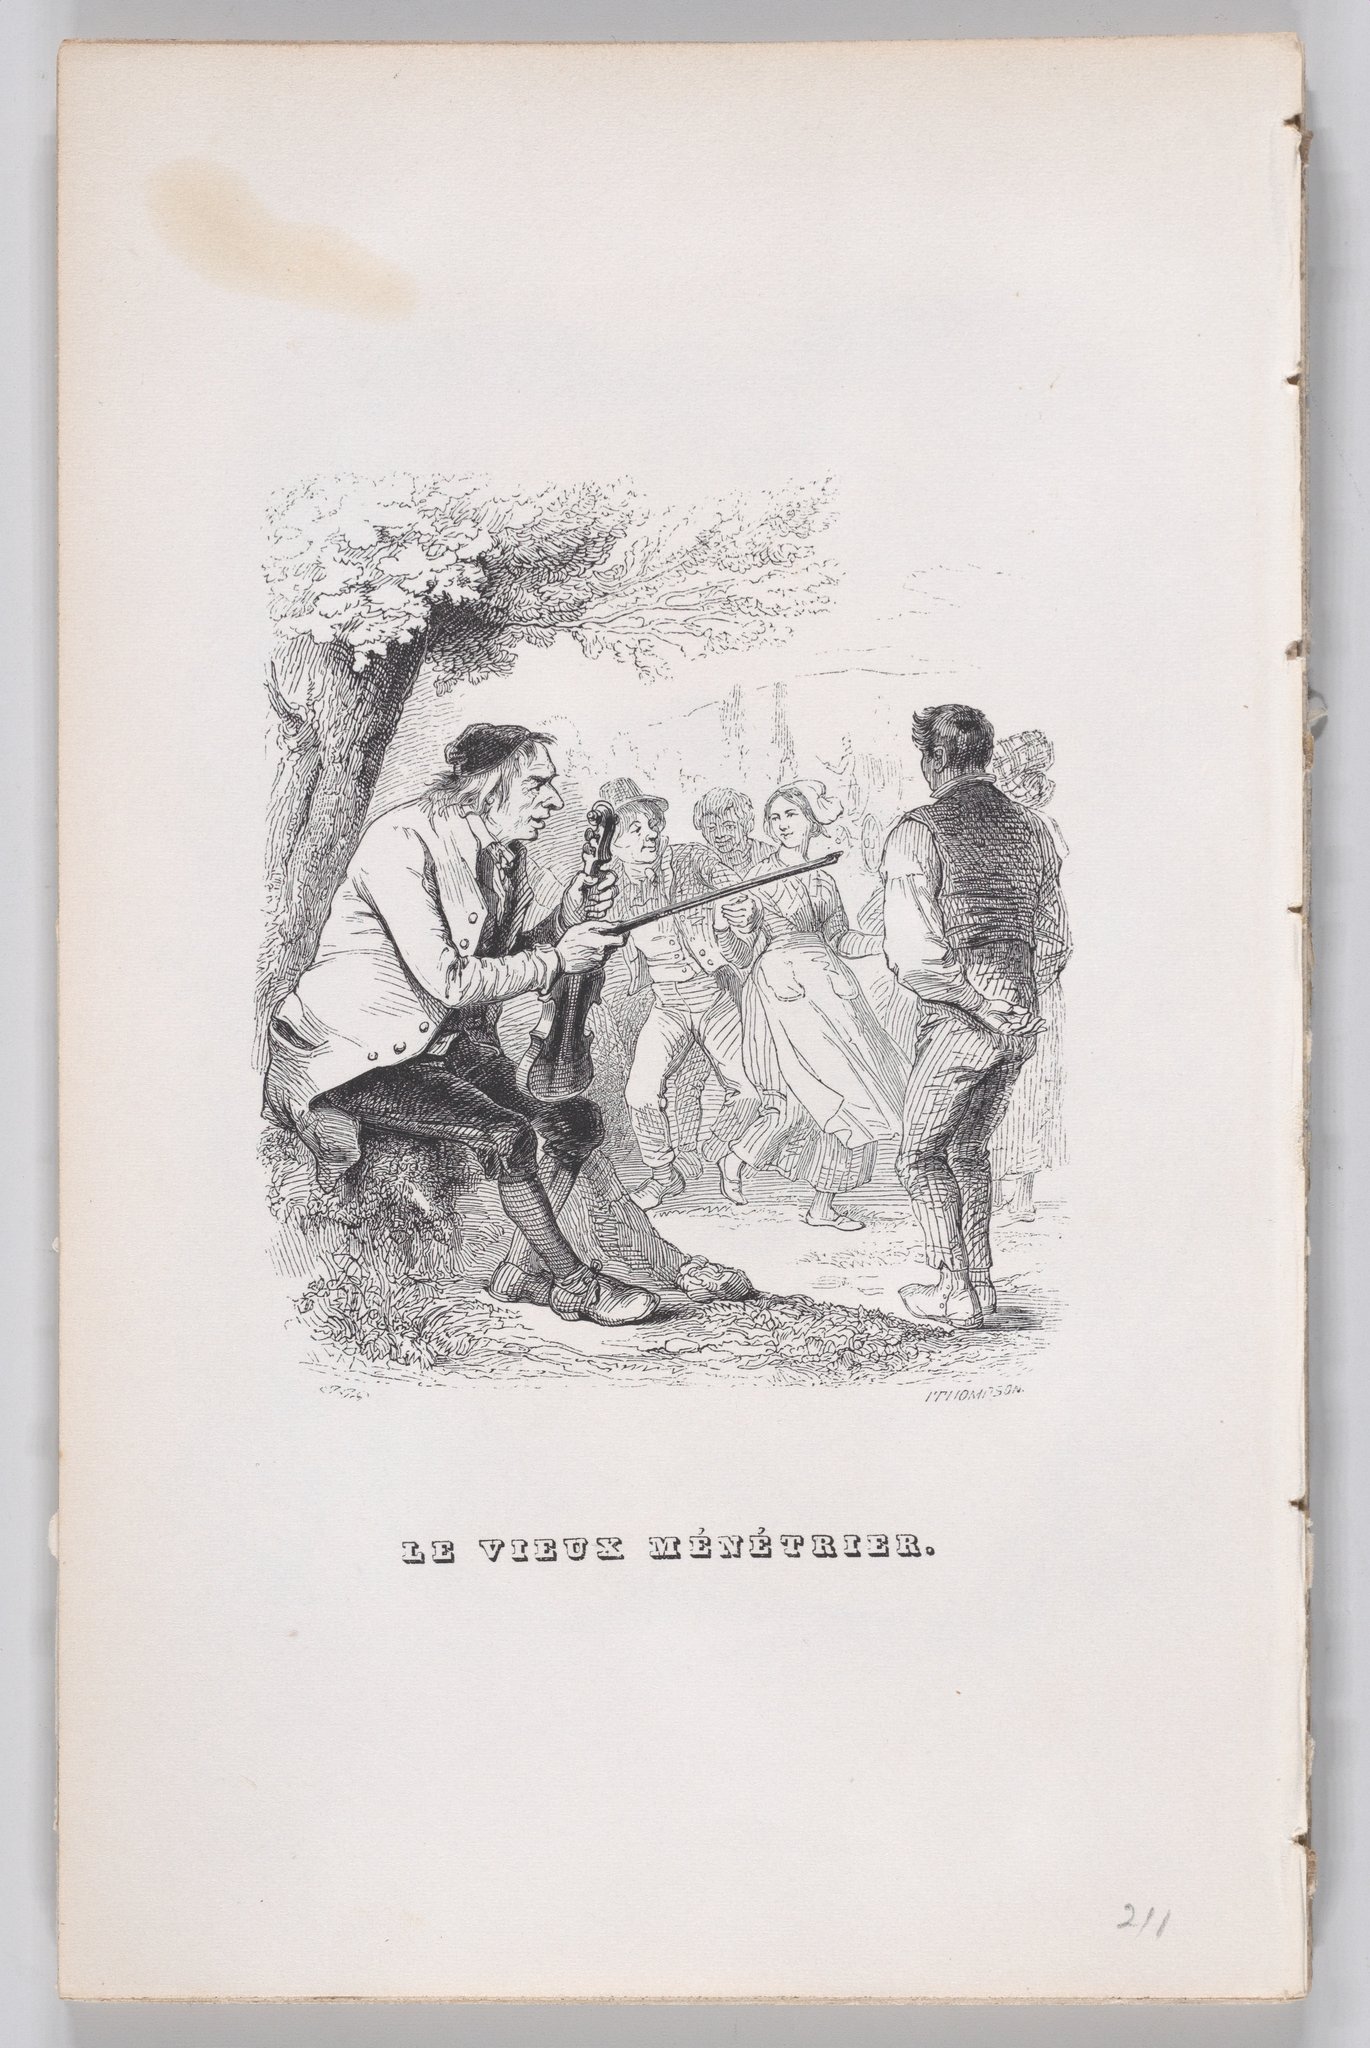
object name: print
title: The Old Minstrel, from "The Complete Works of Béranger"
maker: j. j. grandville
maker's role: illustrator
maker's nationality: french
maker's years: 1803-1847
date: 1836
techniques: engraving